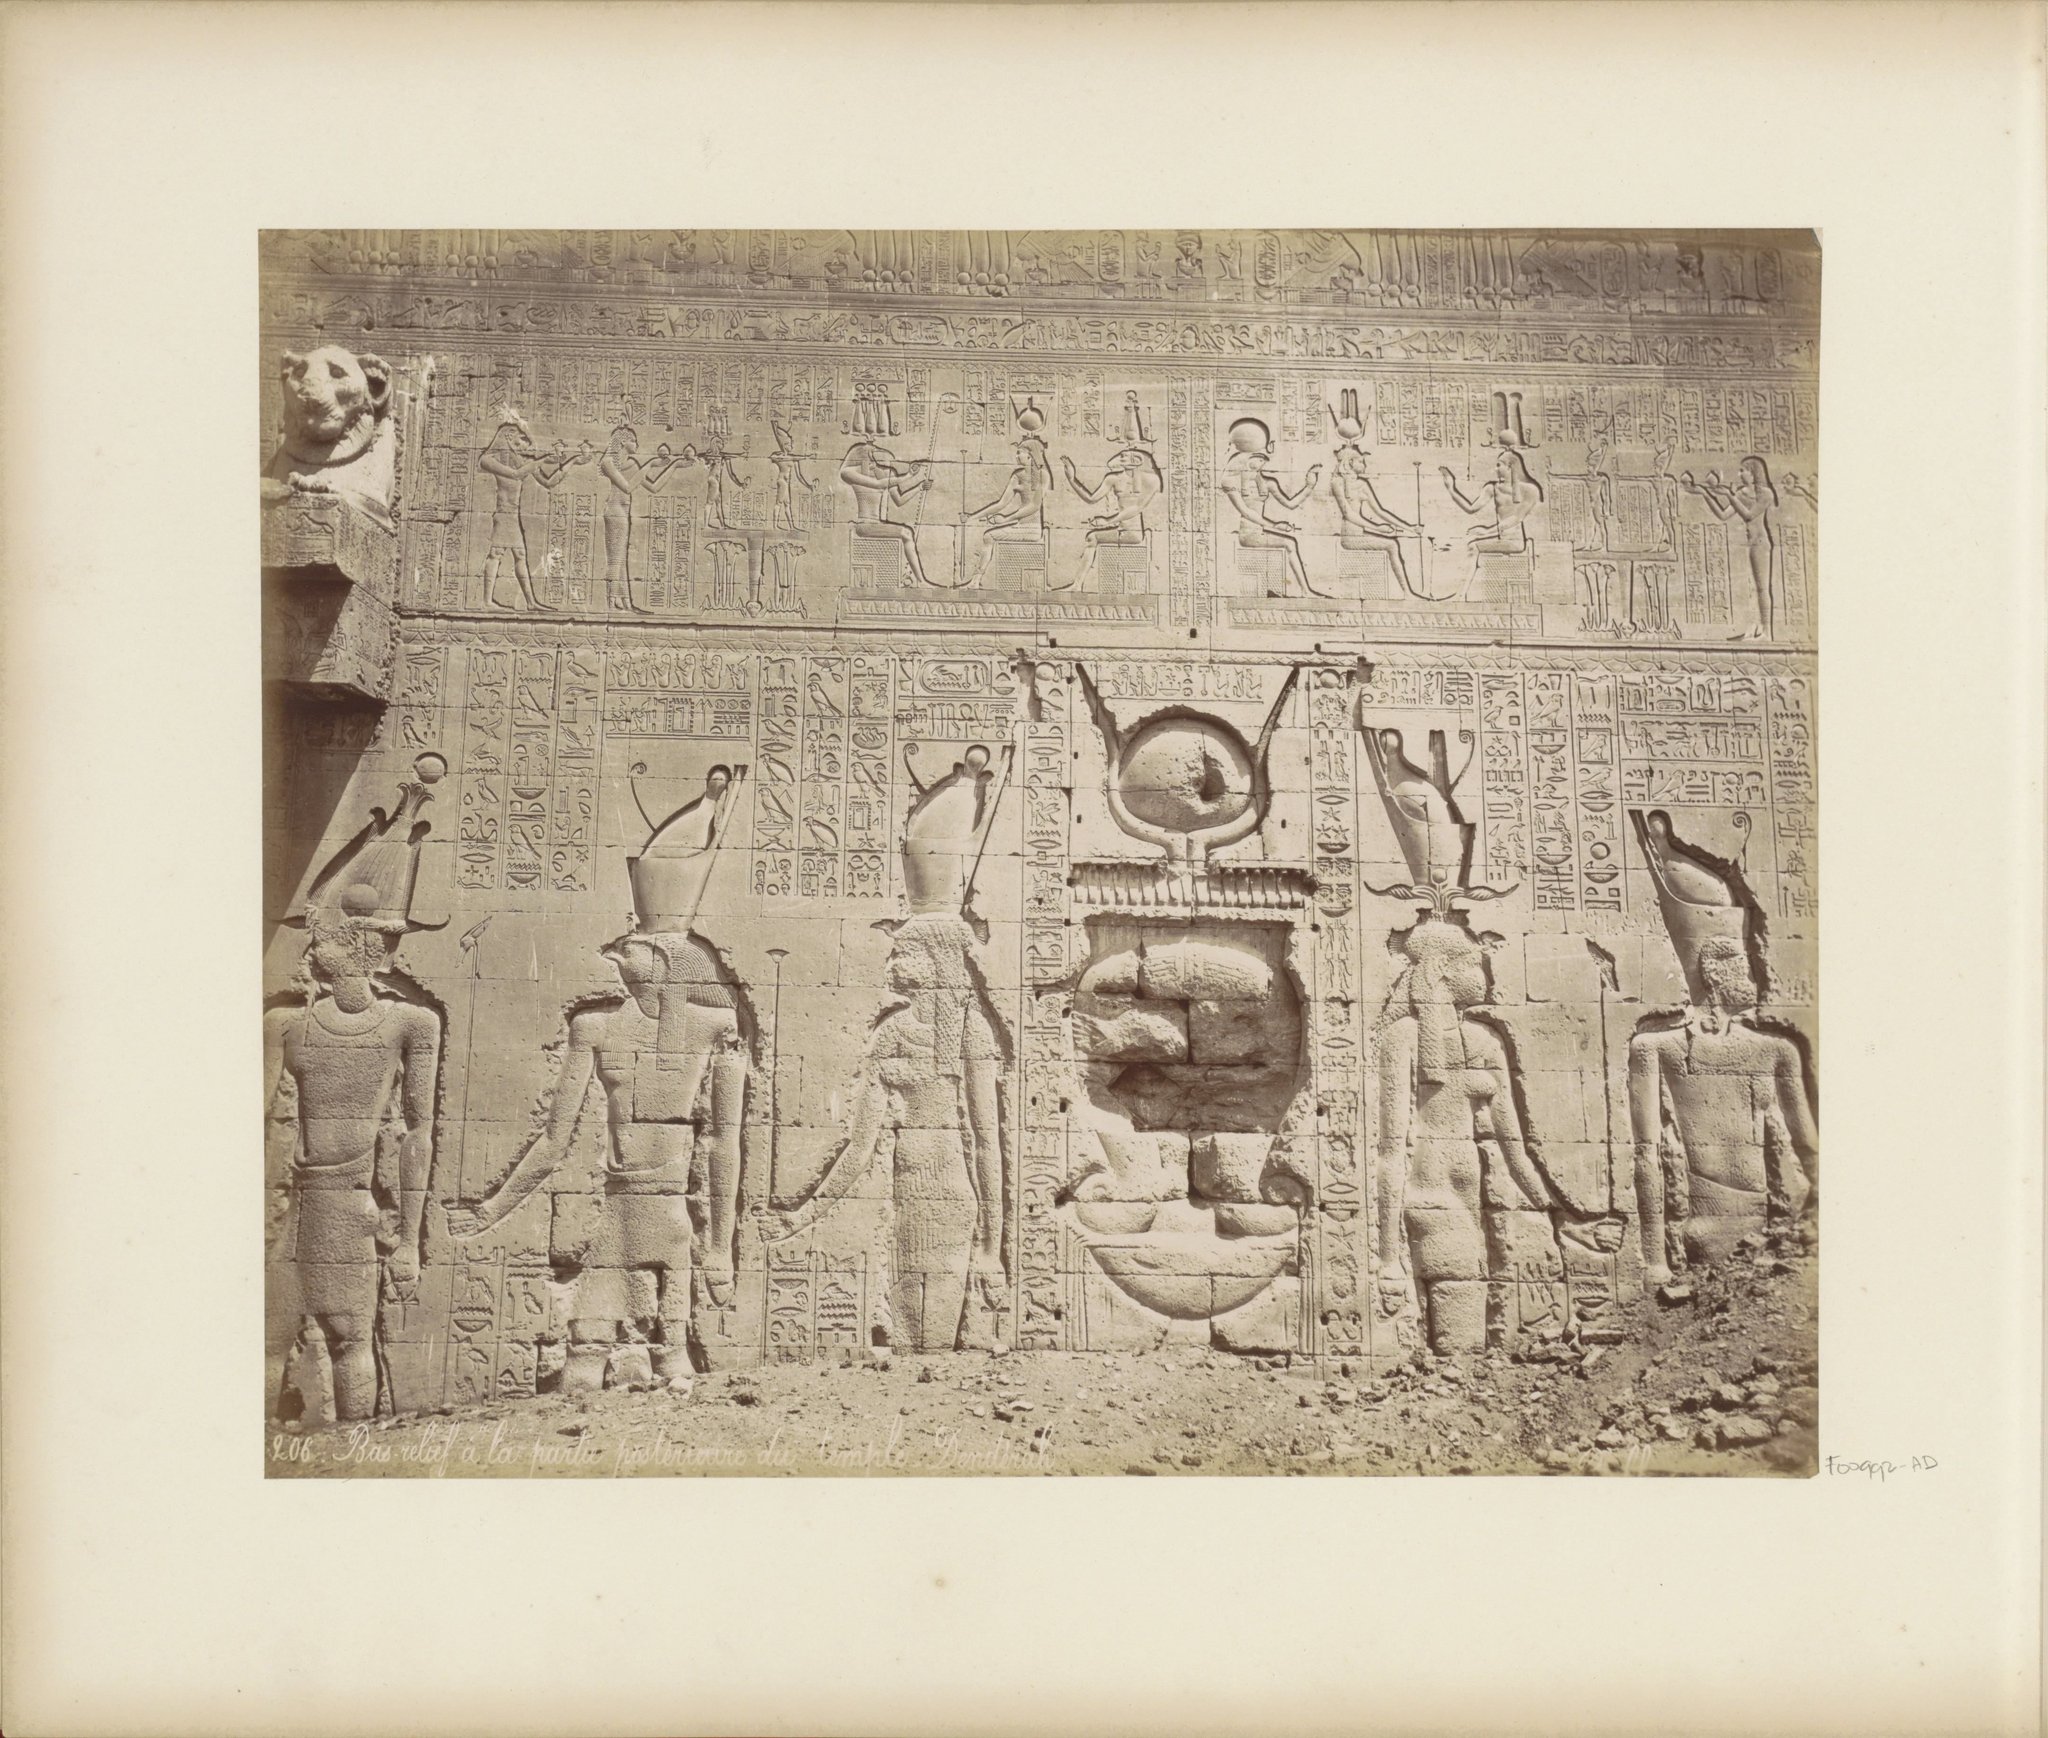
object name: photograph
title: Bas-relief à la partie postériaire du temple Dendérah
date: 1870-1890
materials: cardboard, paper, photographic support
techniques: albumen print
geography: dendera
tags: piece of sculpture, reproduction of a piece of sculpture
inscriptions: negative number: ‘206’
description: Onderdeel van Reisalbum met 80 foto's van Egypte.